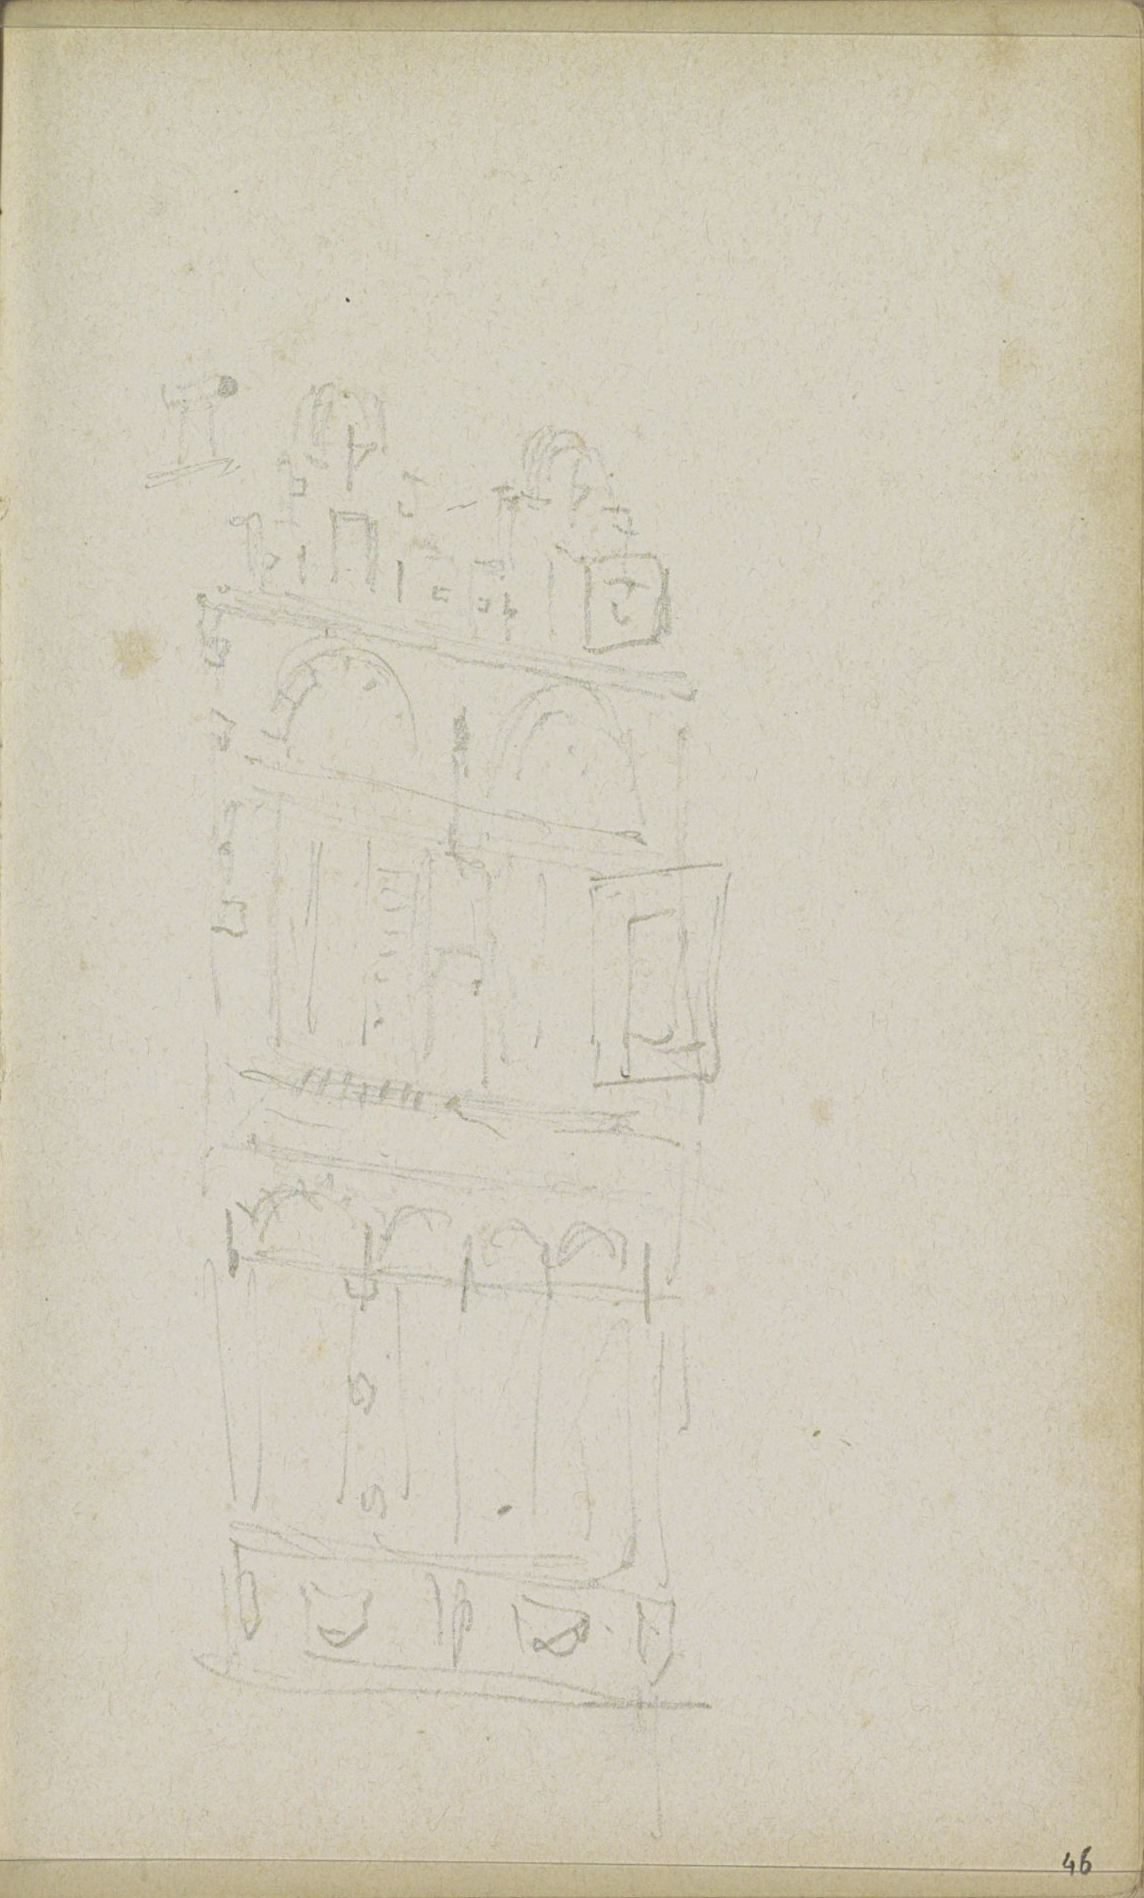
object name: sketchbook leaf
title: Gezicht op een gebouw met trapgevels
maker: adrianus eversen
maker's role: draughtsman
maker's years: 1818-1897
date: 1828-1897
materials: paper, pencil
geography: netherlands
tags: urban housing, decorated gable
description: Gezicht op een gebouw, mogelijk een dubbel pand, met twee trapgevels. Rechts twee geopende luiken. Blad 46 recto uit een schetsboek met 69 bladen vervaardigd in de omgeving van Delft, Rotterdam, Oudewater en Harlingen.